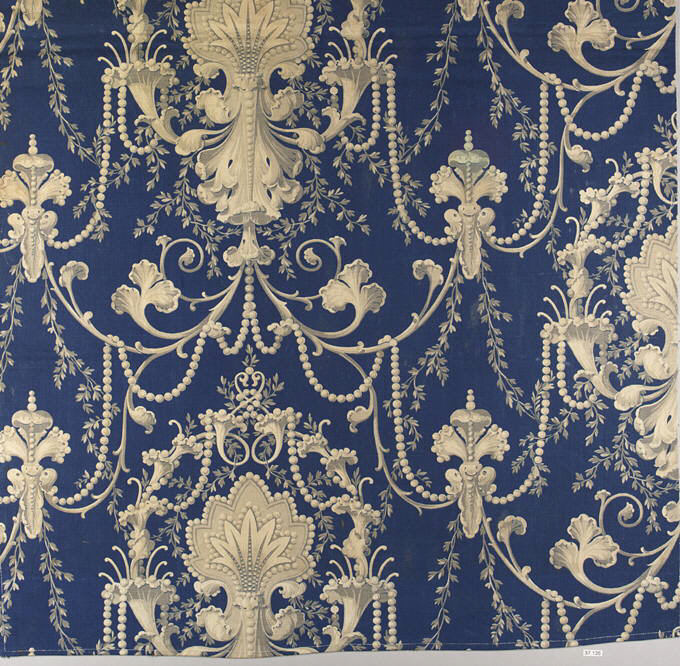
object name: piece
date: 1801-1900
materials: cotton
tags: leaves